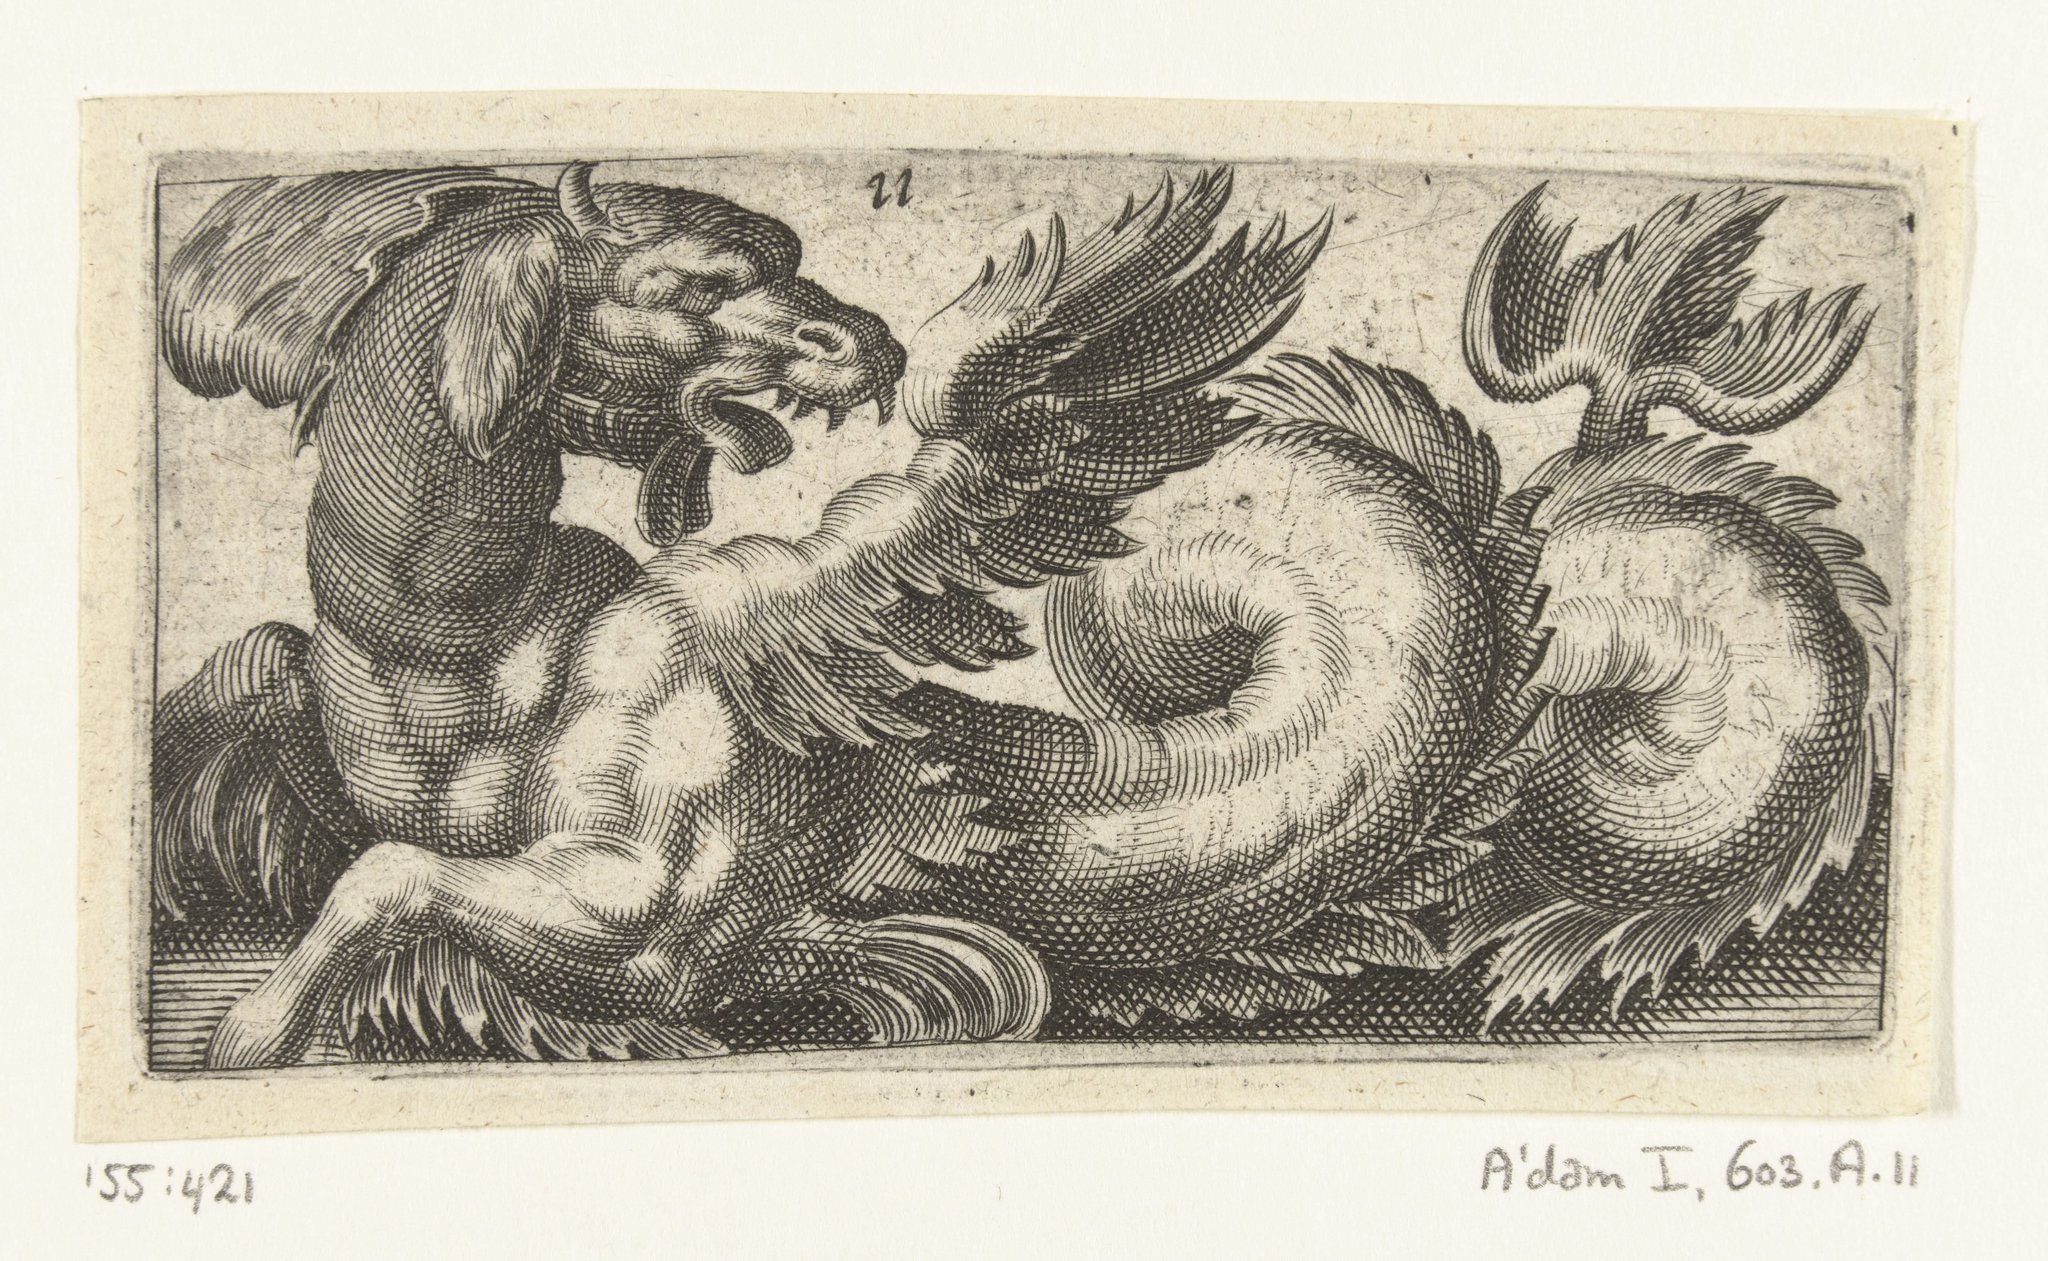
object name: ornament print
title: Friezen met zeemonsters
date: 1526-1606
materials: paper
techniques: engraving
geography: germany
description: Tegenzijdige kopie naar prent met objectnummer RP-P-1984-442.